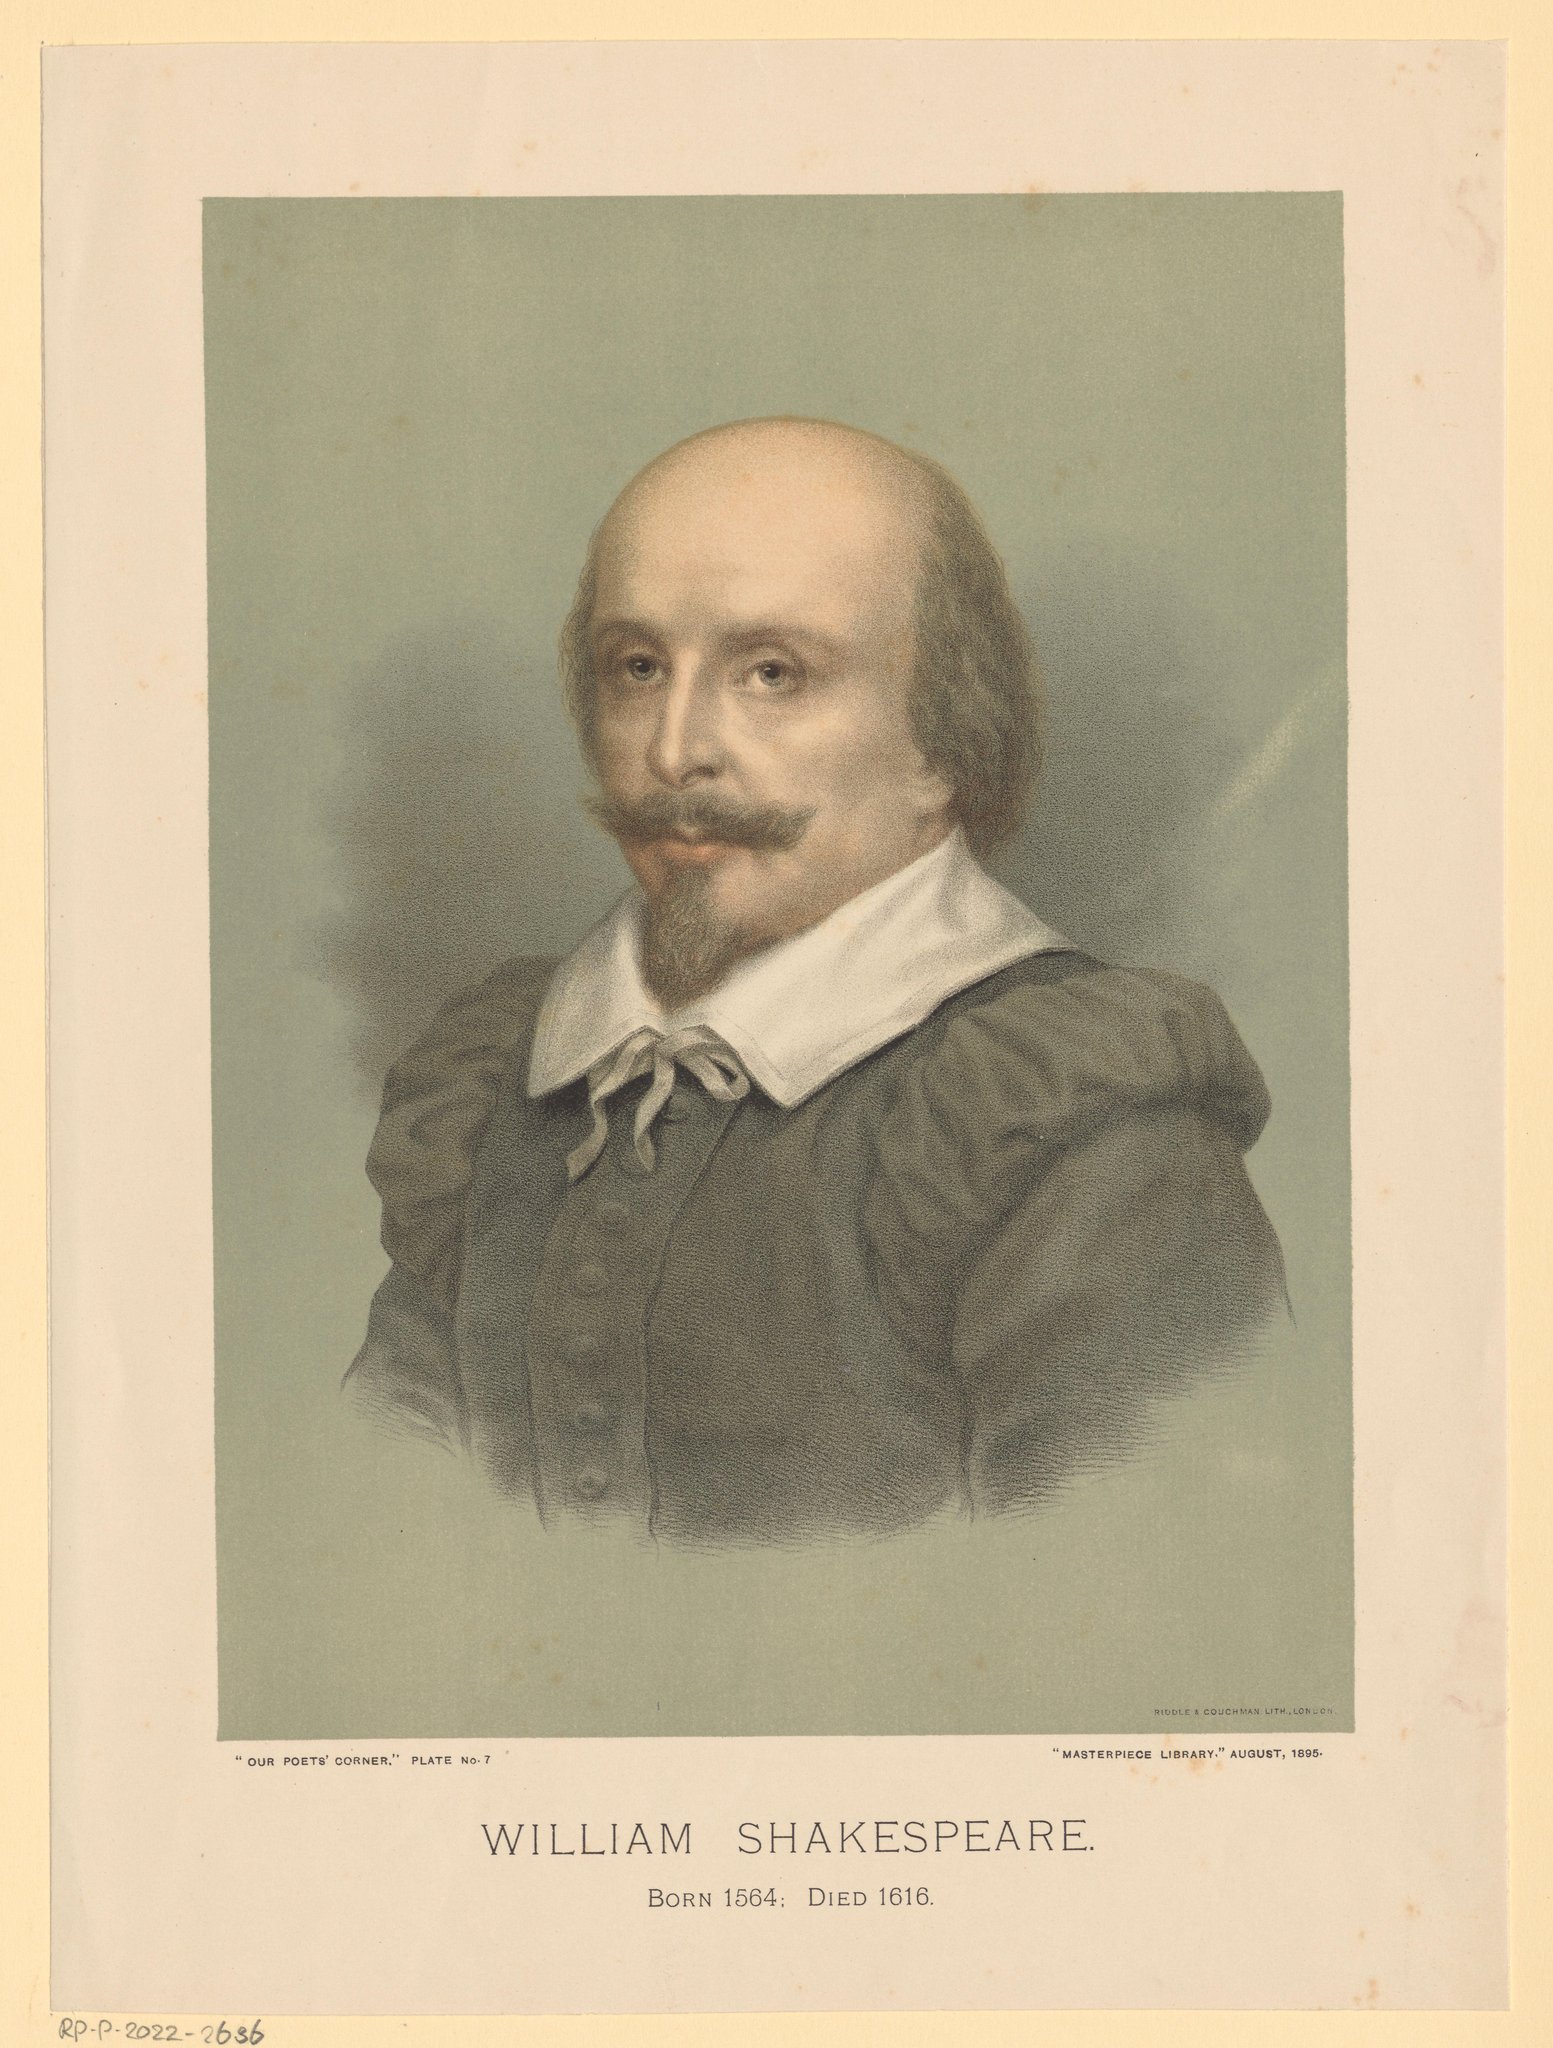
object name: print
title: Portretten van beroemde dichters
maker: Anonymous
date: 1808-1895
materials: paper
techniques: tone lithography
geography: england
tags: william shakespeare, historical persons, portrait of a writer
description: Prent waarschijnlijk uit: Masterpiece Library (1895), augustus 1895.